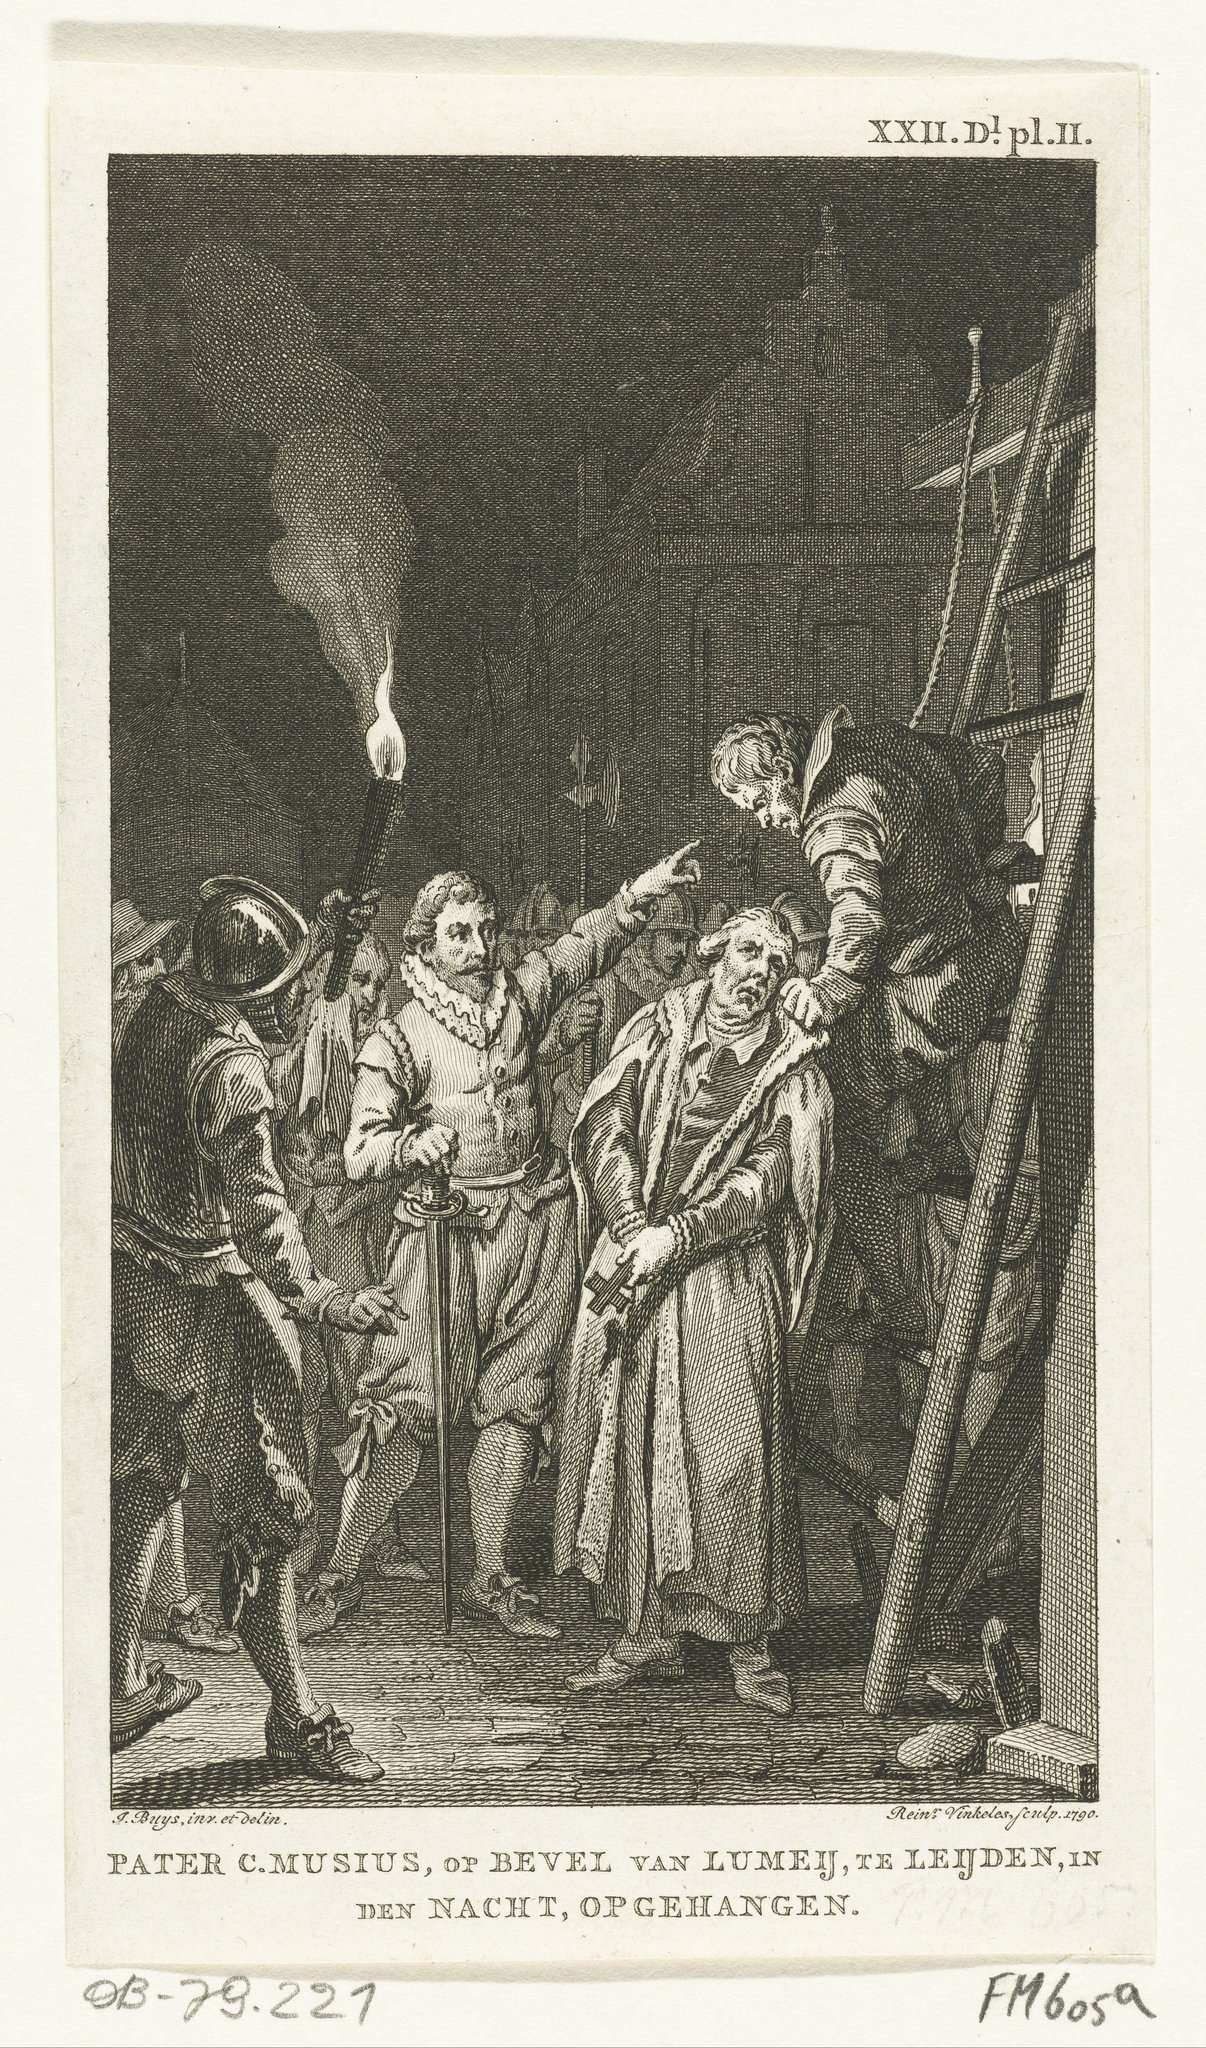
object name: print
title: Pater C. Musius, op bevel van Lumeij, te Leijden, in den nacht, opgehangen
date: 1790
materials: paper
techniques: etching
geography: netherlands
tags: delft, leiden, cornelis musius, violent death by hanging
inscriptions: date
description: Gebruikt als illustratie in: Jacobus Kok, Vaderlandsch Woordenboek, Johannes Allart, Amsterdam 1785-1799, 35 delen, dl. XXII, pl. II. Staat met de letter.